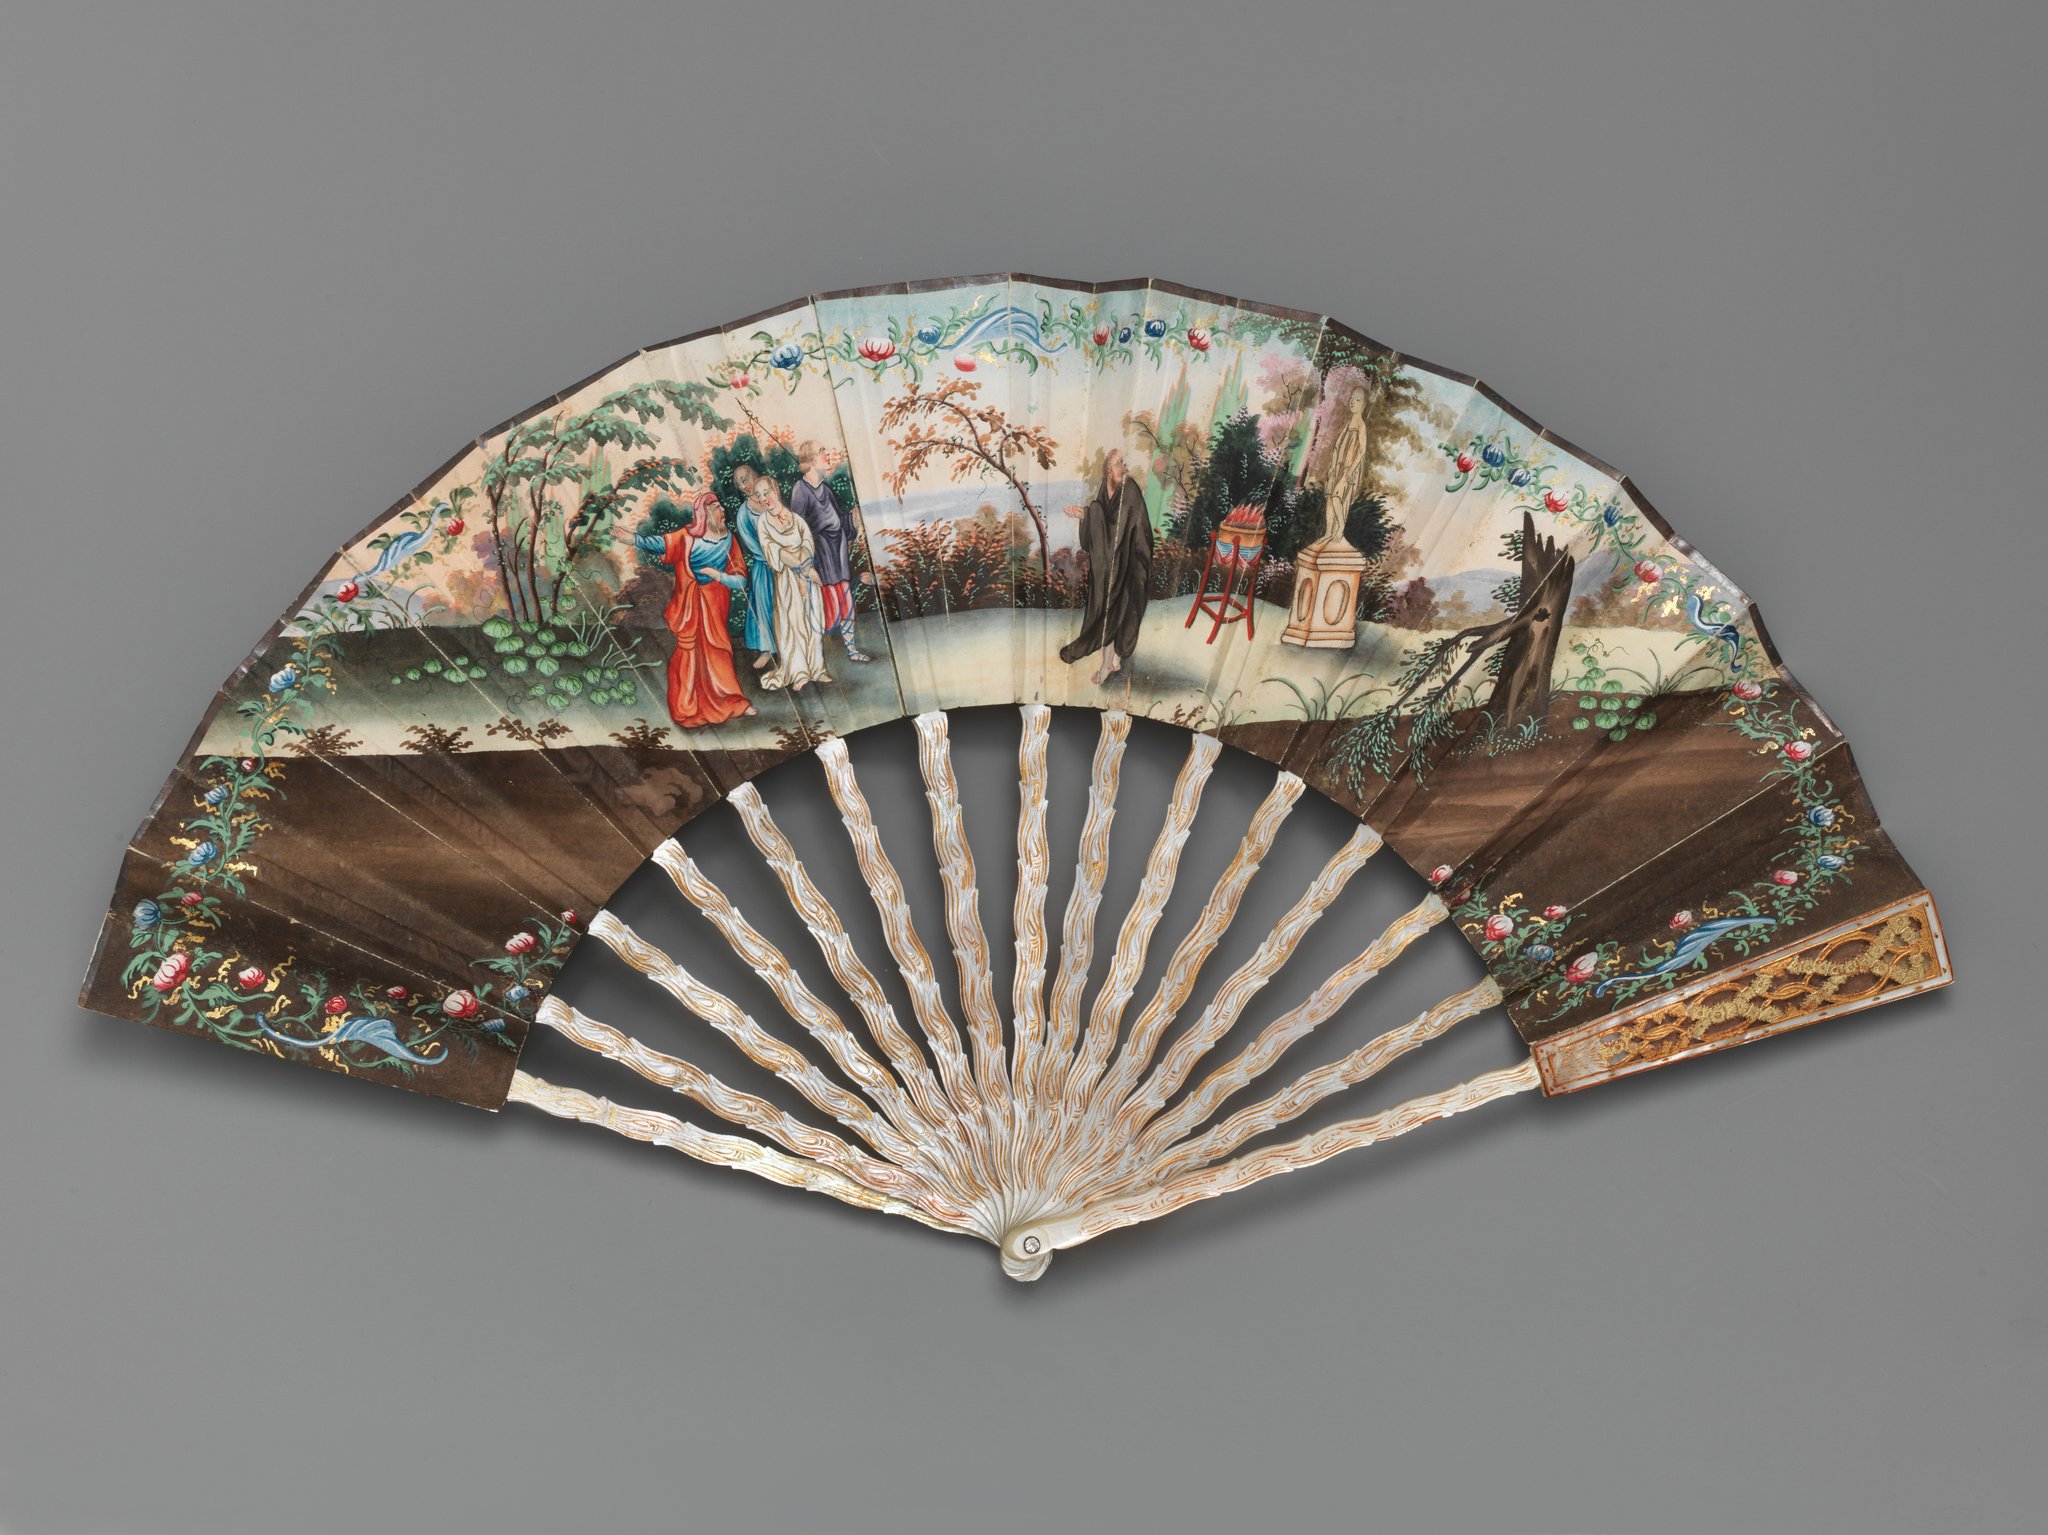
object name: fan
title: Folding Fan with Scene of Figures in a Landscape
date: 1751-1800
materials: mother of pearl, paper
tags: men,women